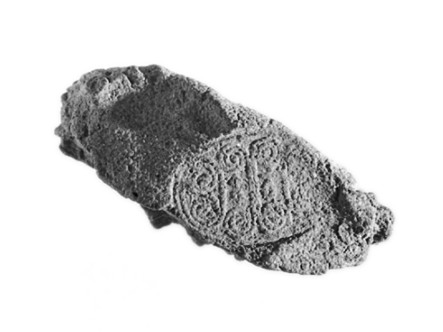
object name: sealing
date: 1981-1640 BCE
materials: mud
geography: egypt